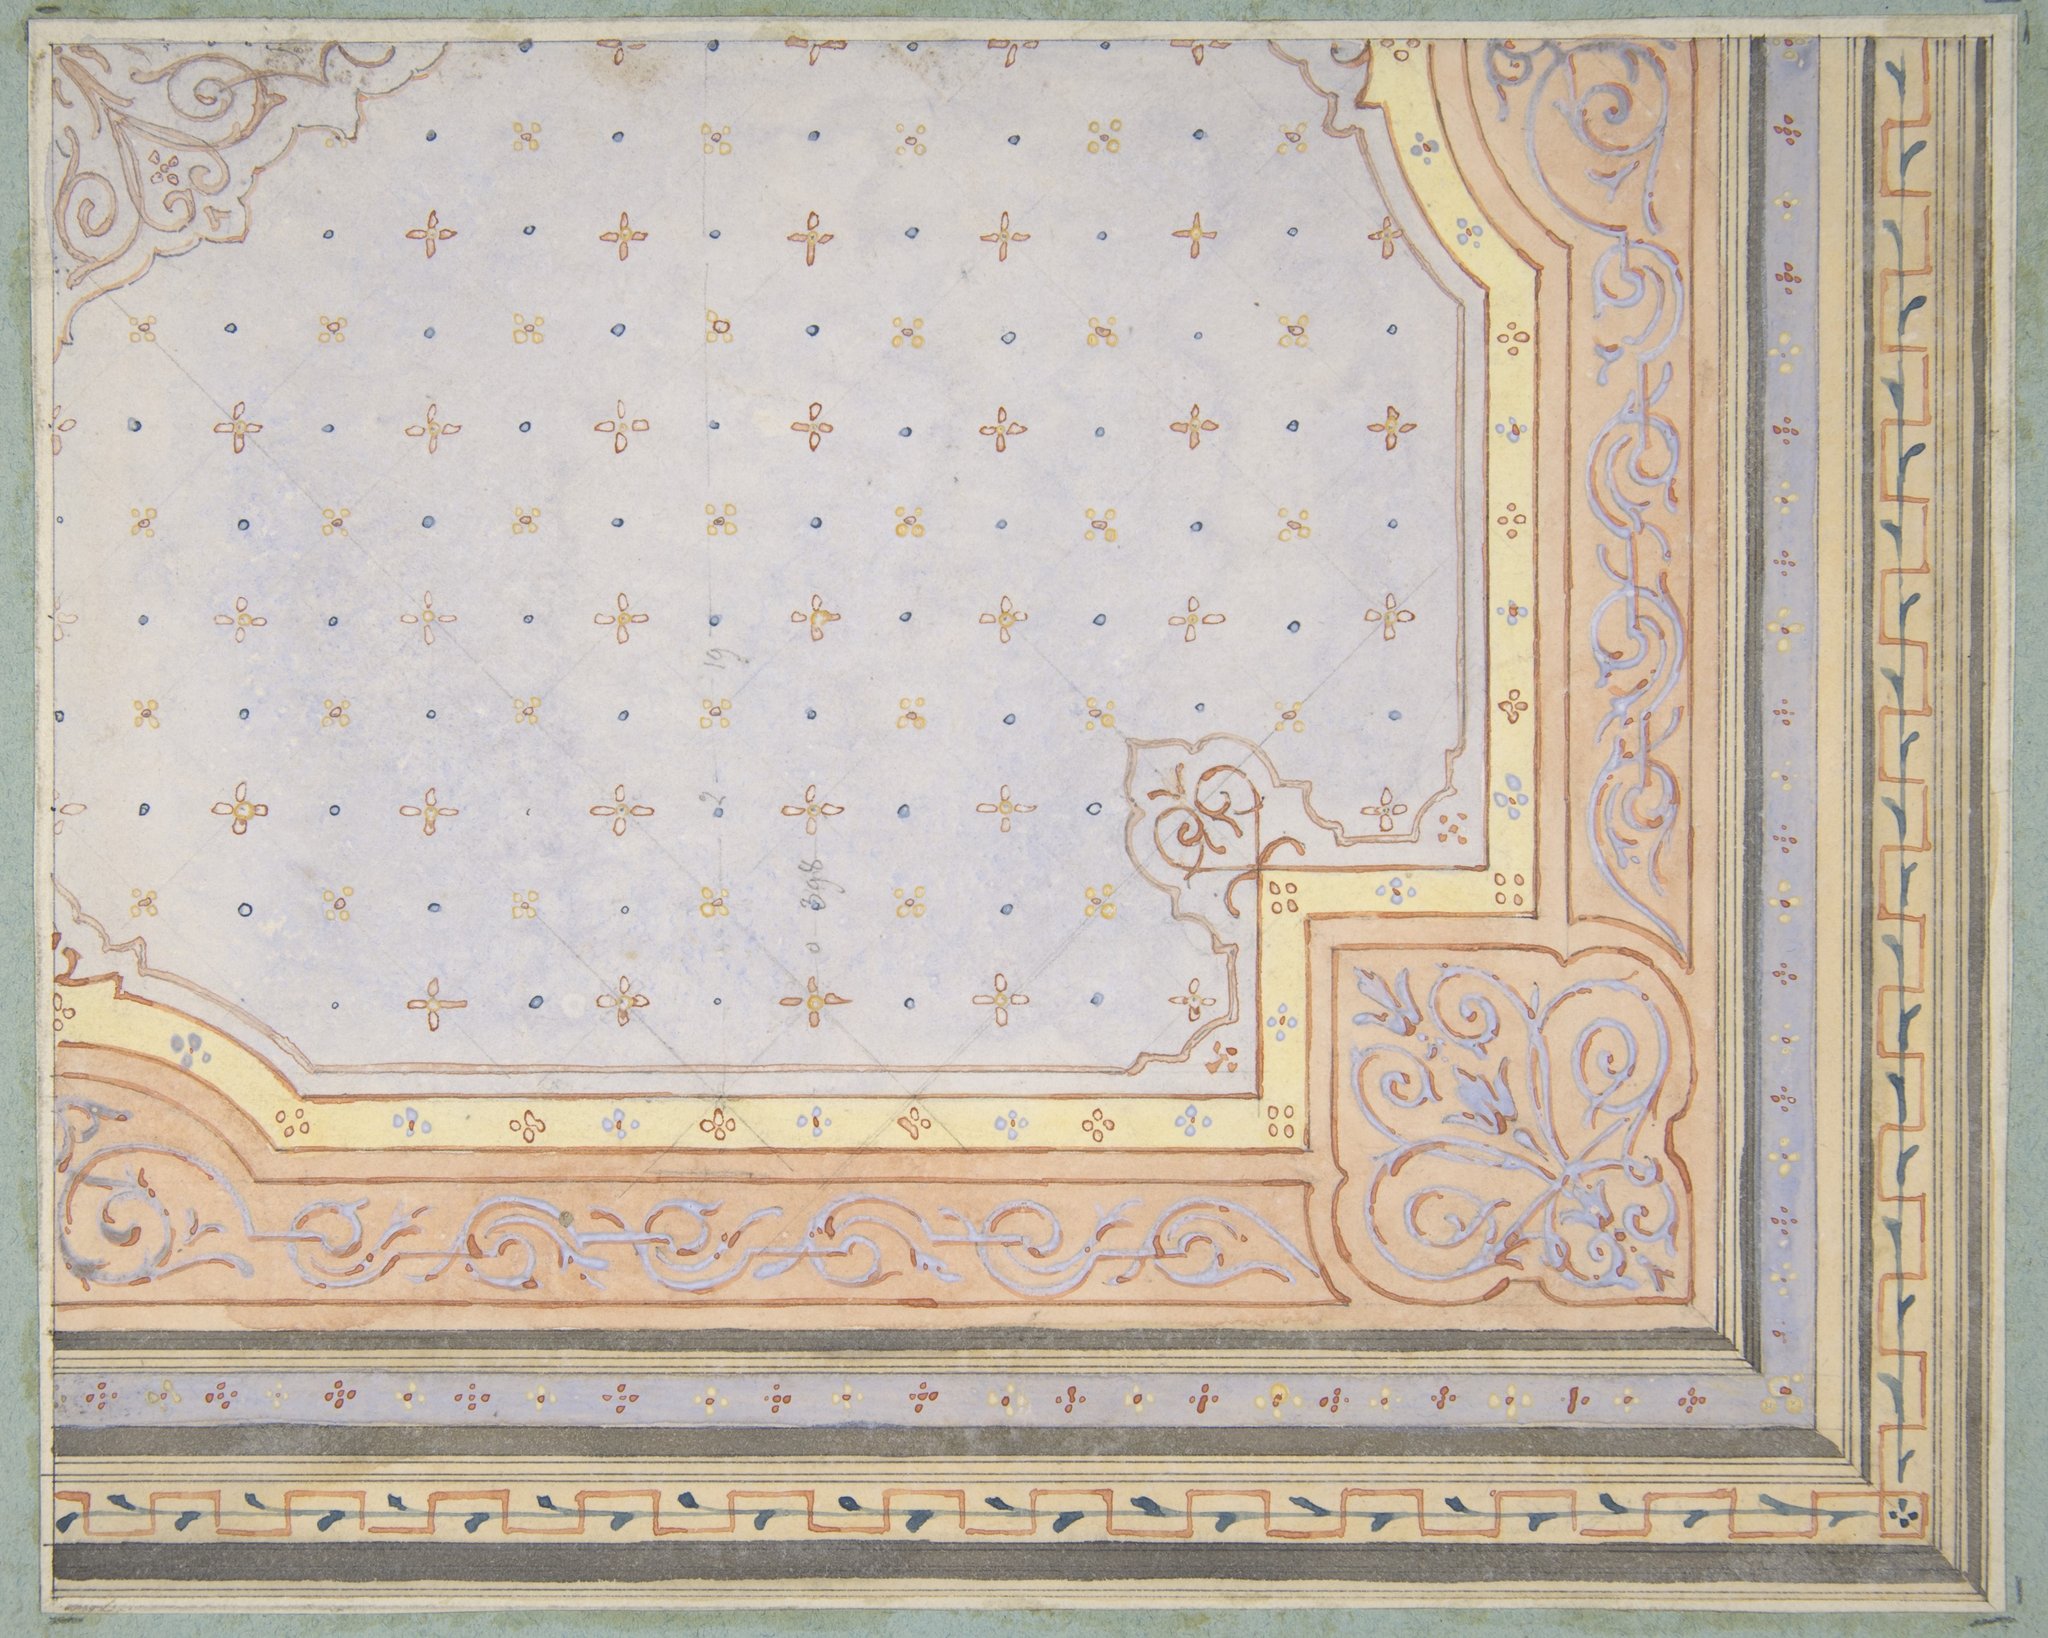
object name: drawing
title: Partial design for the painted decoration of a ceiling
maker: jules-edmond-charles lachaise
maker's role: artist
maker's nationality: french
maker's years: 1897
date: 1830-1897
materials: gouache, graphite, ink, watercolor, paper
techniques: pen